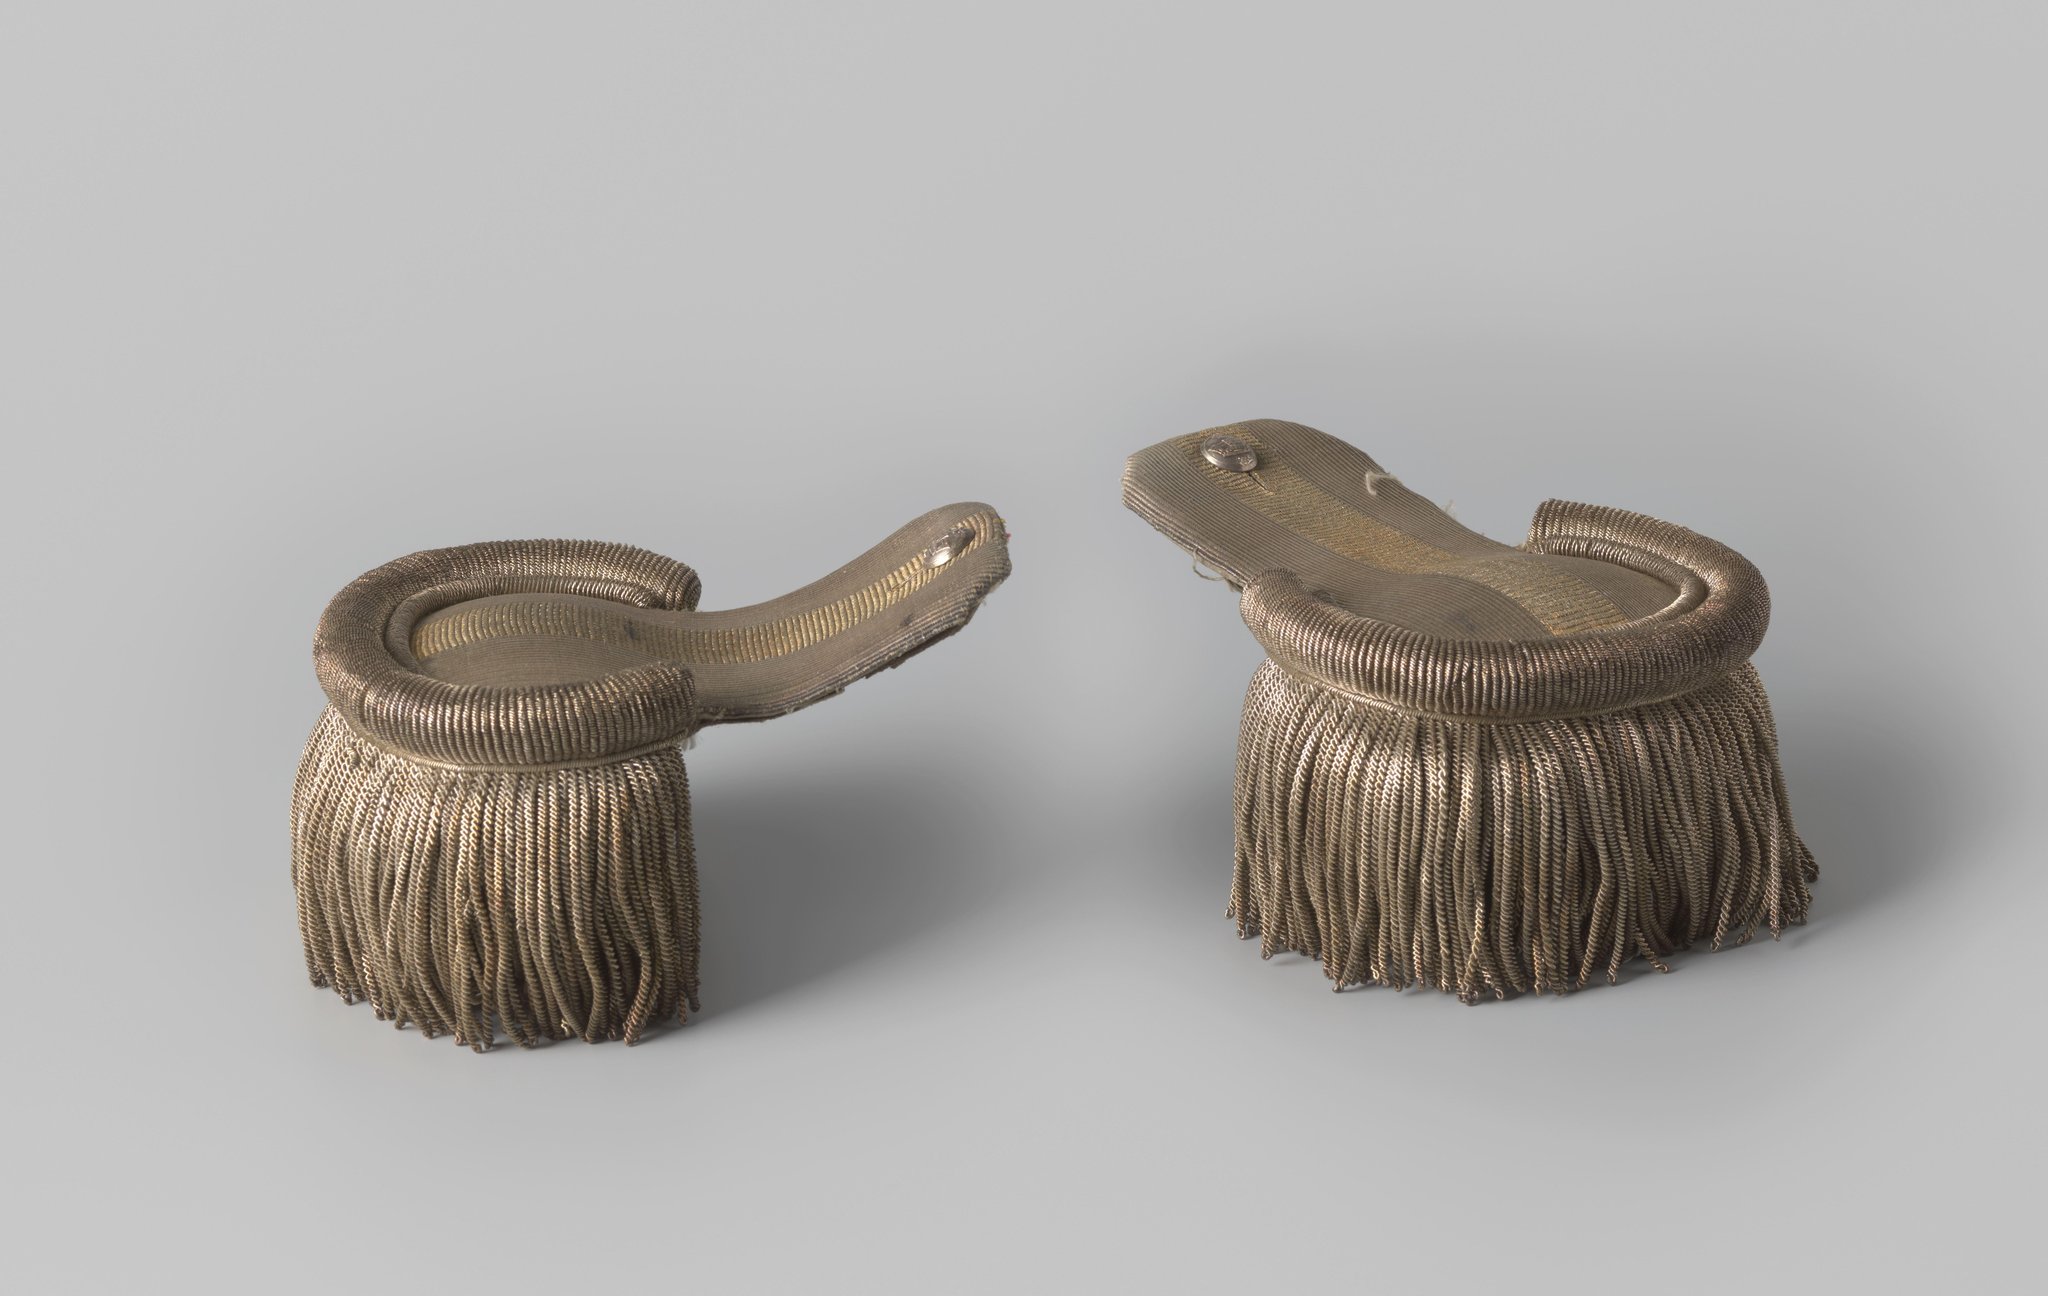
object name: uniform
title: Epaulet van zilverdraad, met één gouden streep en met torsades (dunne franjes), onderdeel van een schutterij-uniform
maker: becker (kleermaker)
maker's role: kleermaker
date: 1809-1829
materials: gold thread, thread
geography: amsterdam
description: Epaulet van zilverdraad, met één gouden streep en met torsades (dunne franjes), onderdeel van een schutterij-uniform.